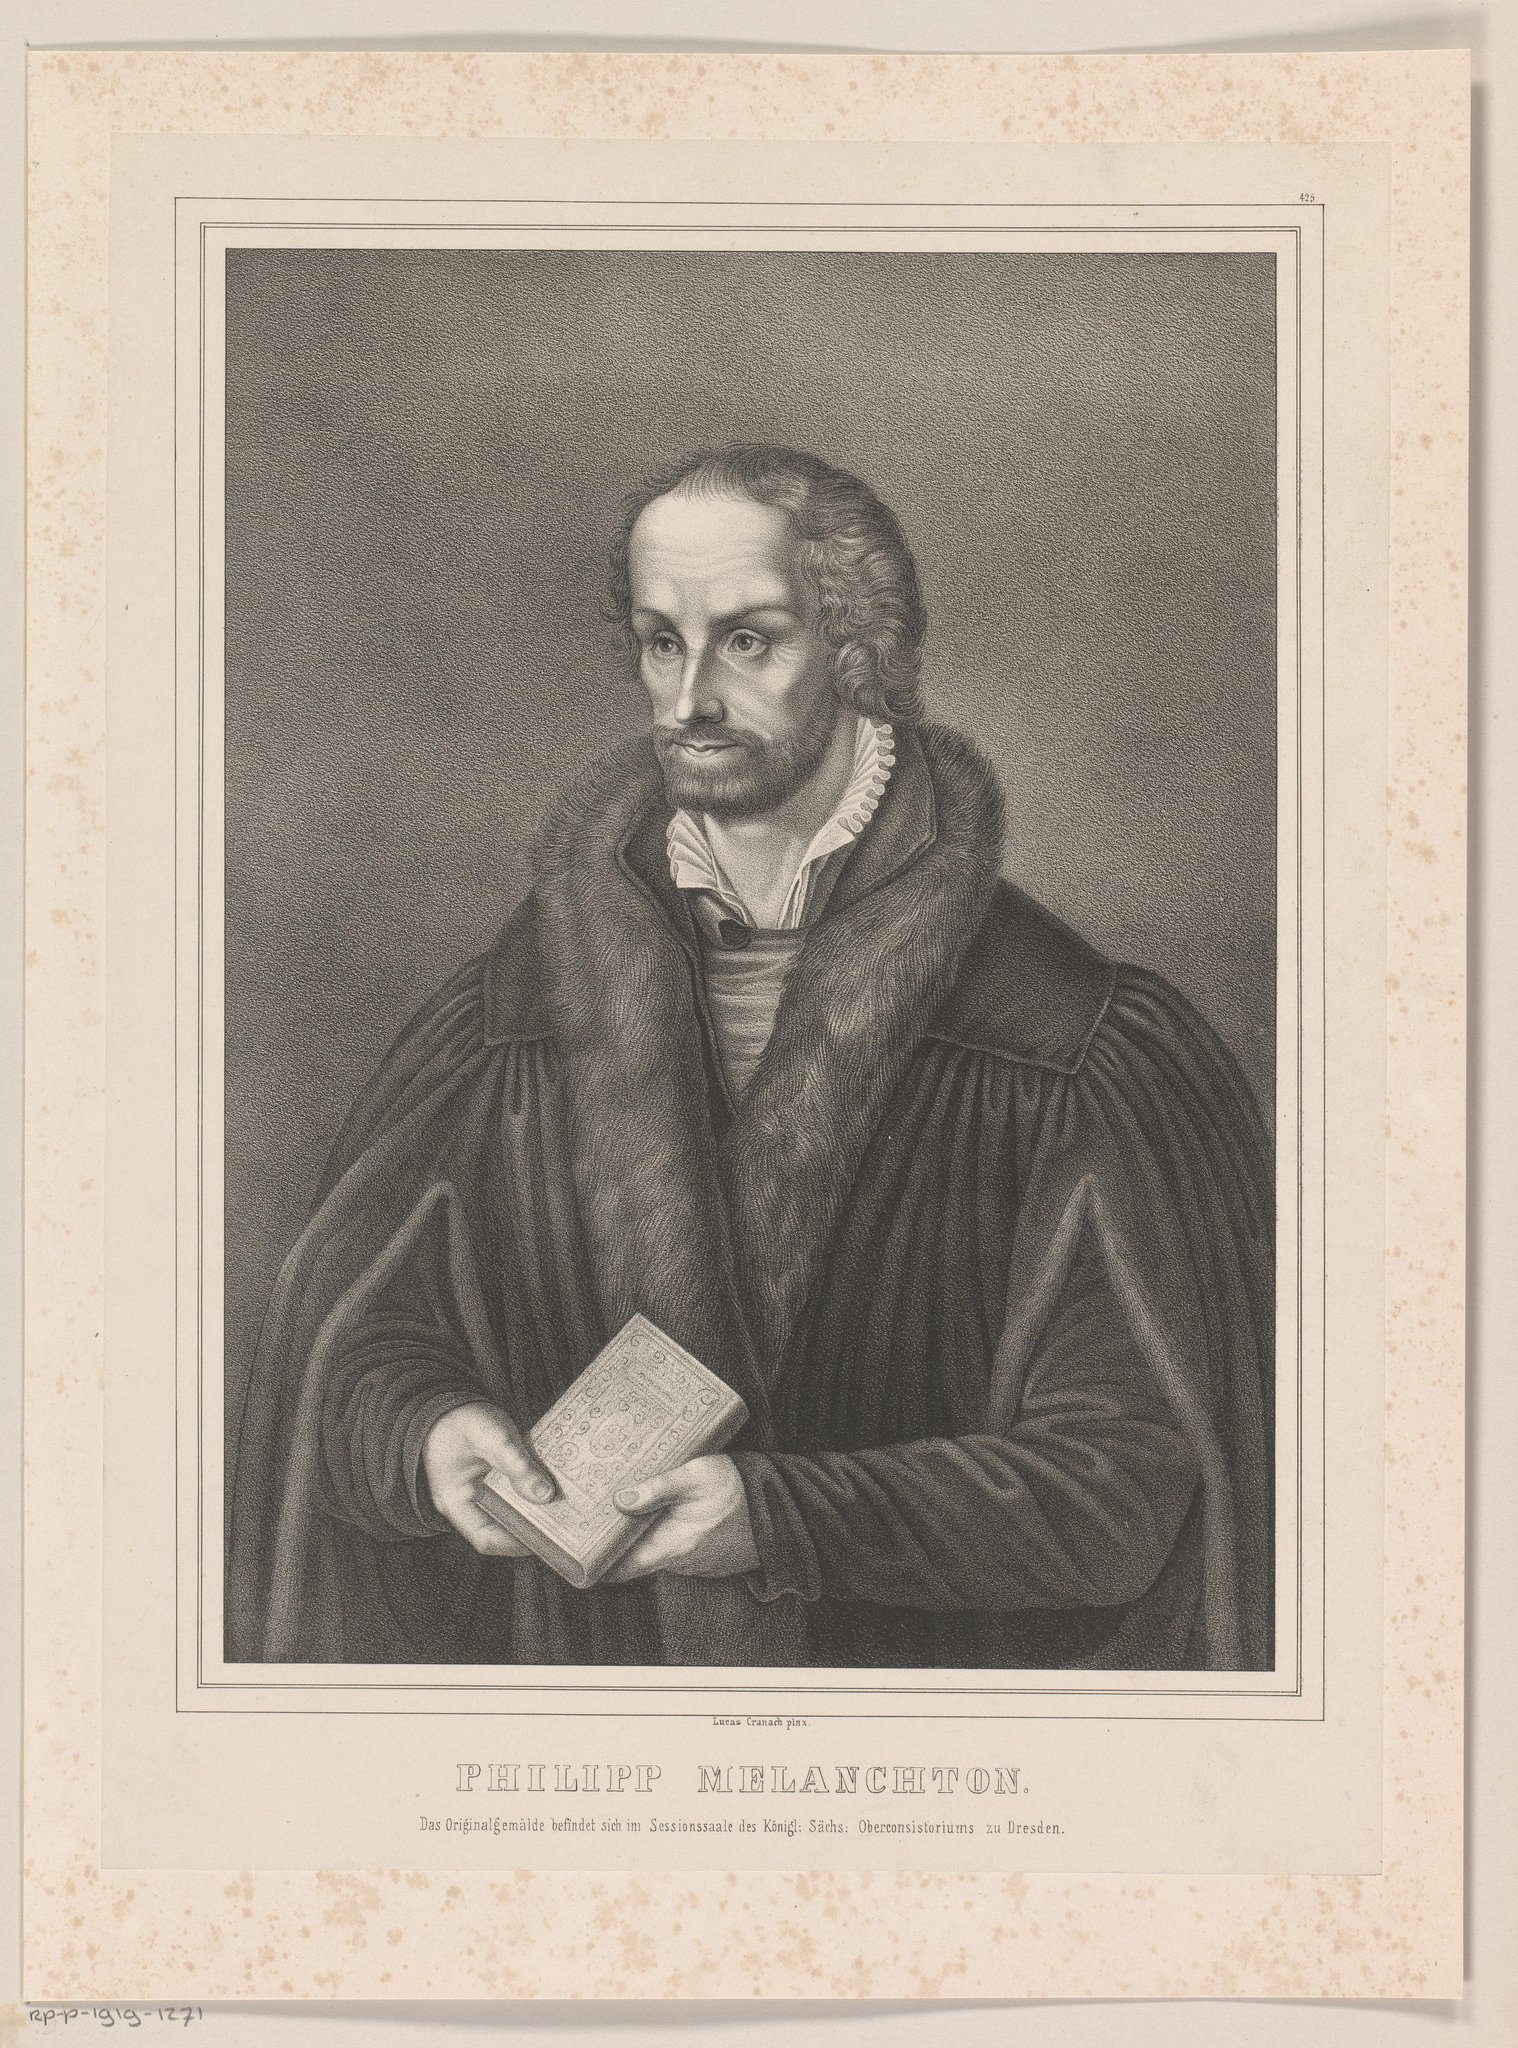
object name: print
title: Philipp Melanchton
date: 1800-1950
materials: paper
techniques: lithograph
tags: theologian, historical persons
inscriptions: collector's mark: Lugt 2228